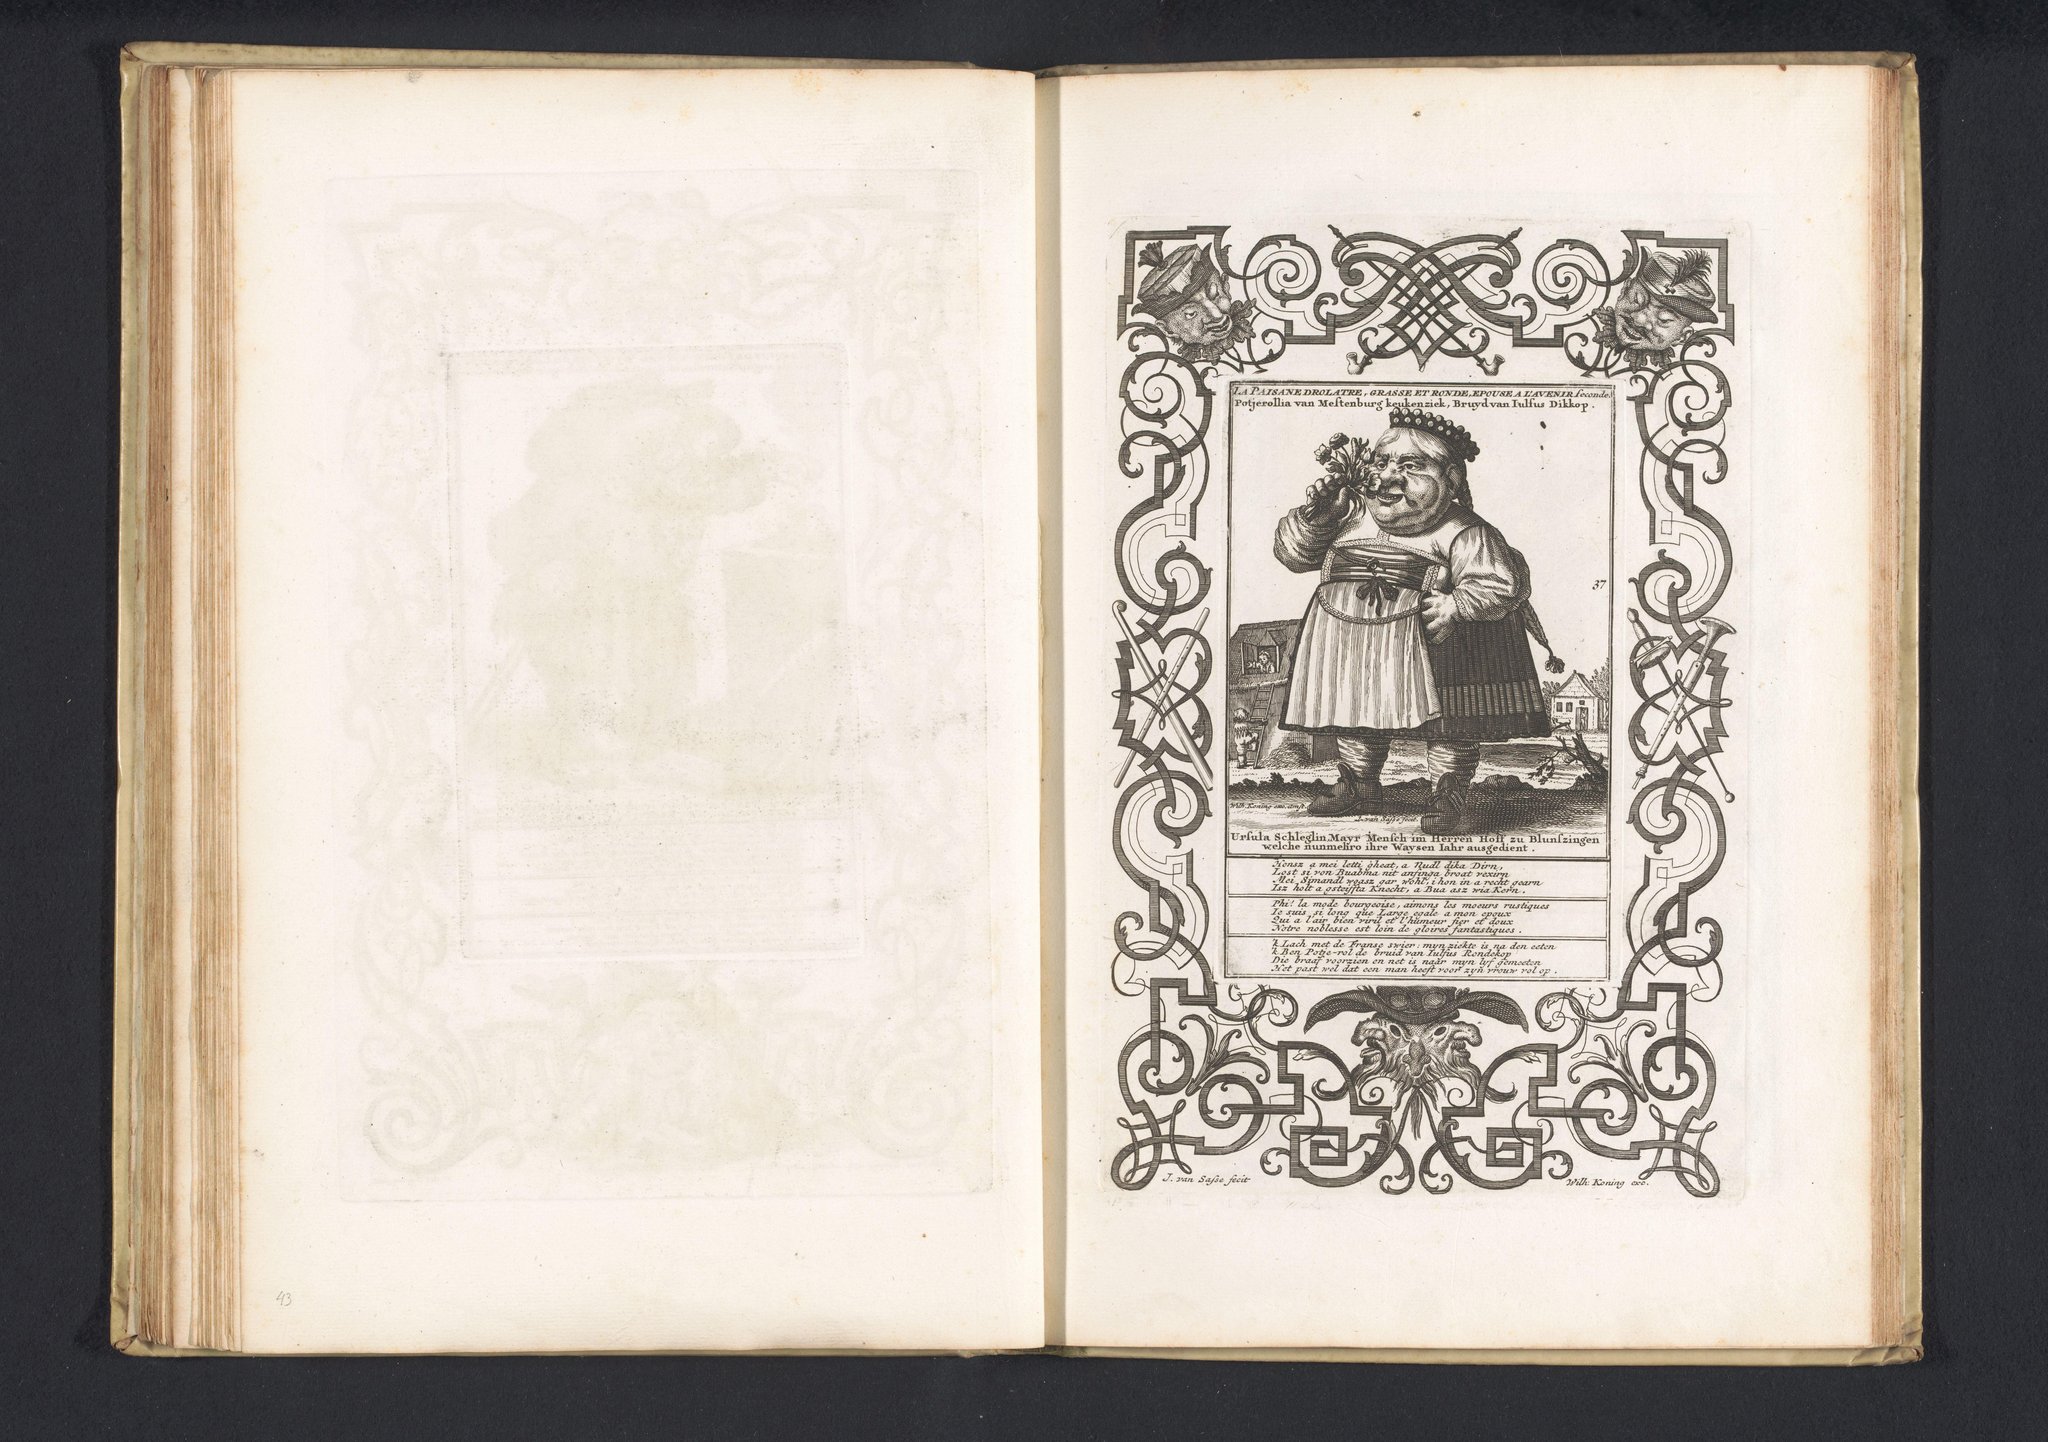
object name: print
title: La Paisane Drolatre, grasse et ronde, epouse a l'avenir feconde / Potjerollia van Mestenburg, keukenziek, Bruyd van Justus Dikkop / Ursula Schleglin, Mayr Mensch im Herren Hoff zu Blunszingen welche nunmehro ihre Waysen Iahr ausgedient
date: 1716-1720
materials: paper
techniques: etching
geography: northern netherlands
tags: caricatures (human types), little people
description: De kleine mens Potjerollia van Mestenburg als boerin. In het onderschrift verzen in het Duits, Frans en Nederlands. Genummerd rechts midden: 37. Afdruk binnen een decoratieve omlijsting gedrukt van een aparte plaat met koppen van Chinese kleine mensen en maskers. Onderdeel van deel II in de tweede Nederlandse gebonden uitgave uit 1720 (en gerelateerd aan de Windhandel in dat jaar) van een serie karikaturen van kleine mensen, bekend als Het Dwergentooneel, deels gekopieerd naar een ouder Duits voorbeeld.